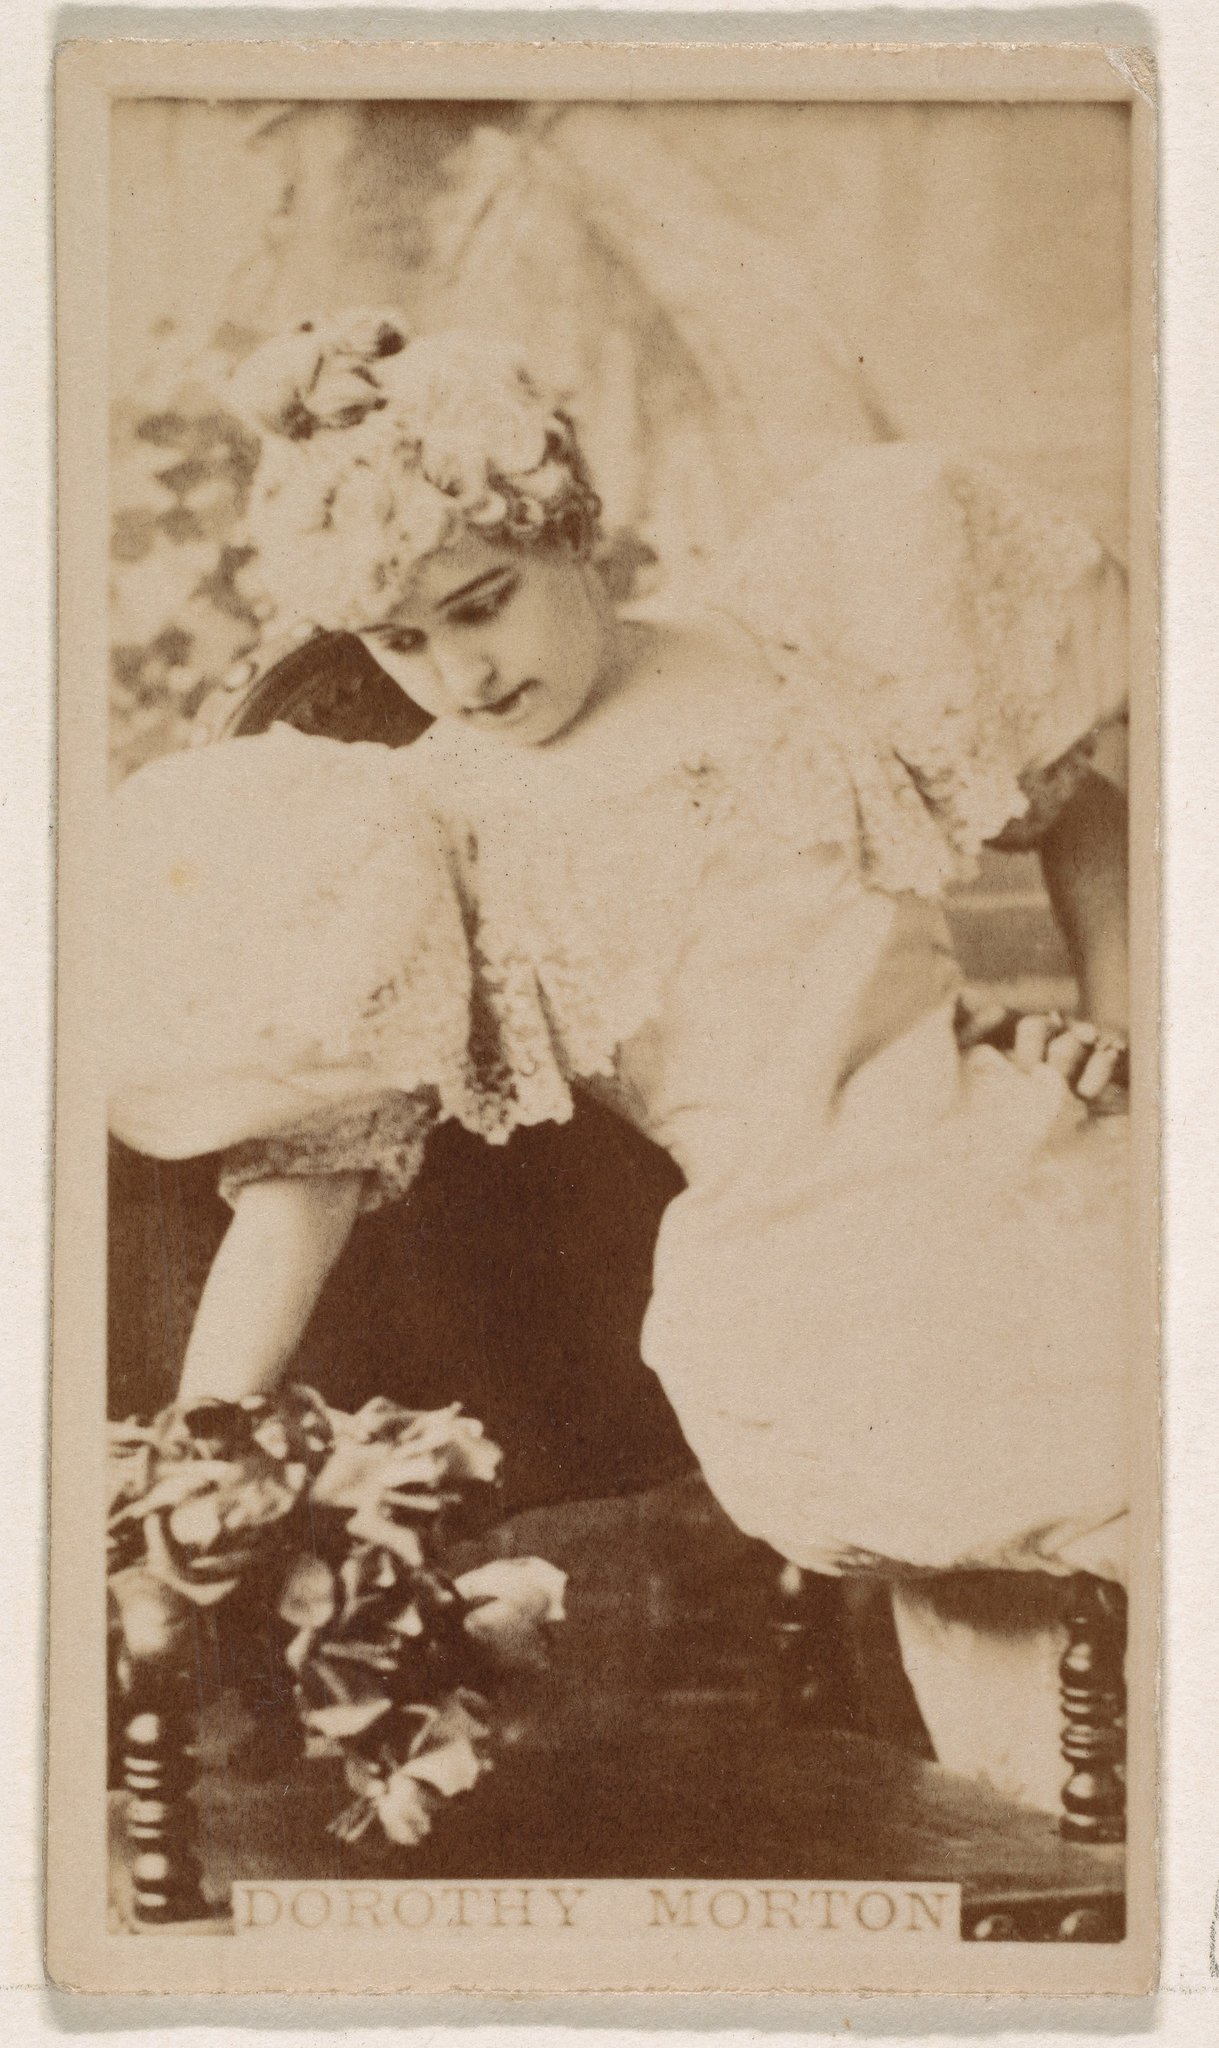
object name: photograph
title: Dorothy Morton, from the Actresses series (N245) issued by Kinney Brothers to promote Sweet Caporal Cigarettes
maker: kinney brothers tobacco company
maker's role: publisher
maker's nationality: american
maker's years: 1869-2011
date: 1890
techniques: albumen silver print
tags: portraits,women,actresses